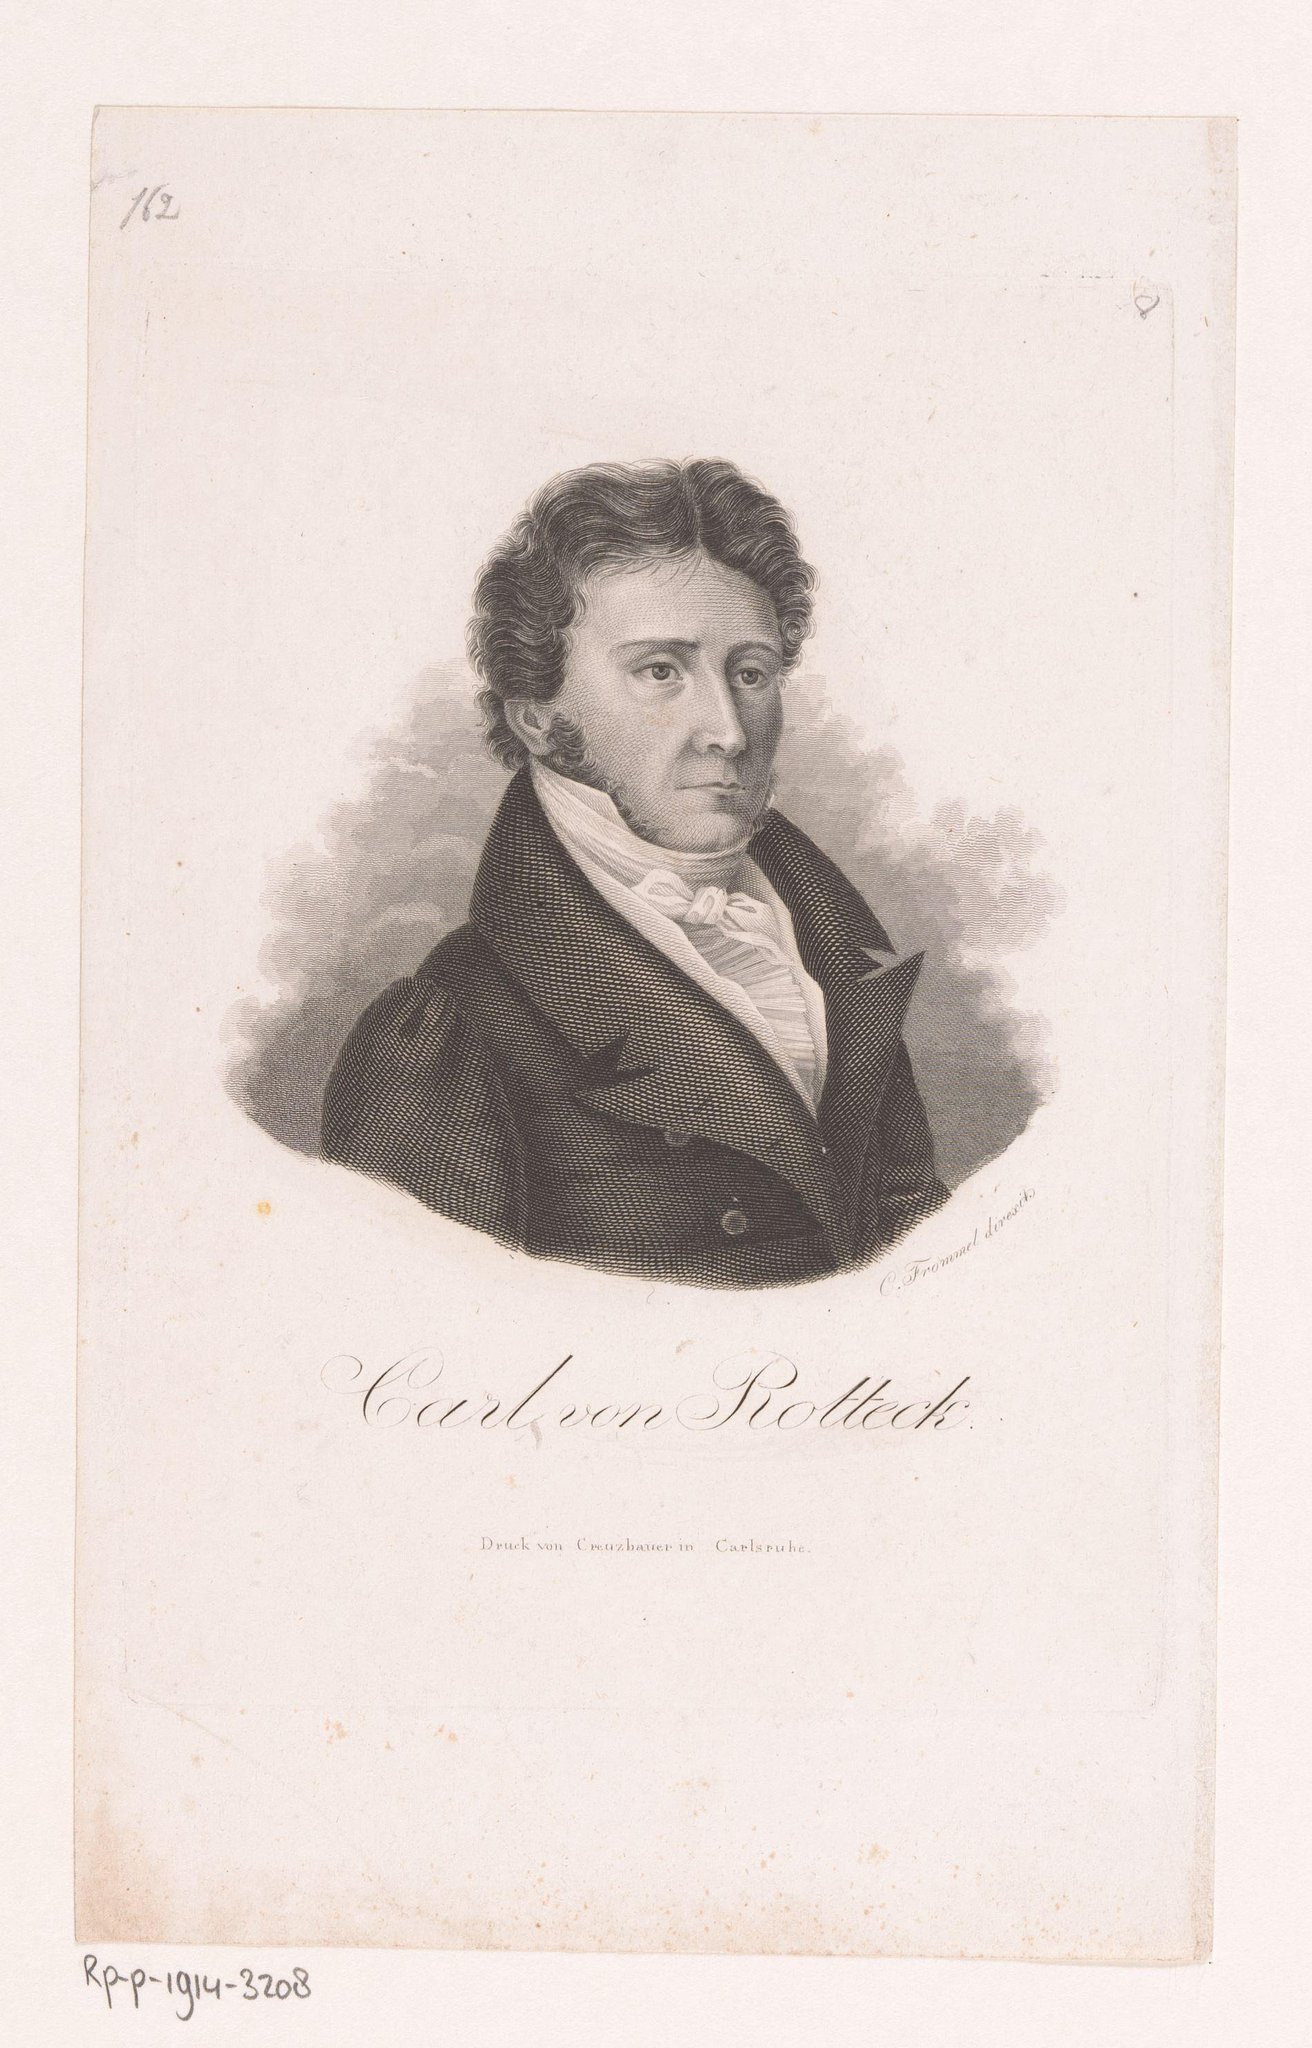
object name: print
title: Portret van Karl von Rotteck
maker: carl ludwig frommel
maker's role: print maker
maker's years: 1789-1863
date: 1799-1840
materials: paper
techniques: engraving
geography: karlsruhe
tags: historical persons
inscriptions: collector's mark: Lugt 2228